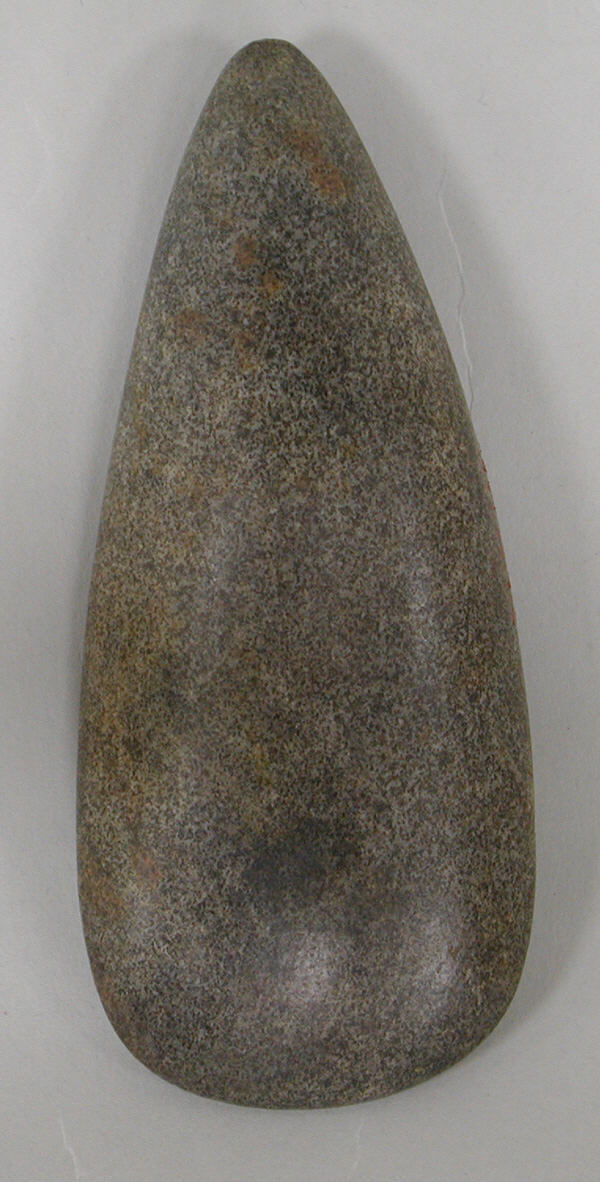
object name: celt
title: Stone Celt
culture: taíno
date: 1501-1600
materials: stone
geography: dominican republic